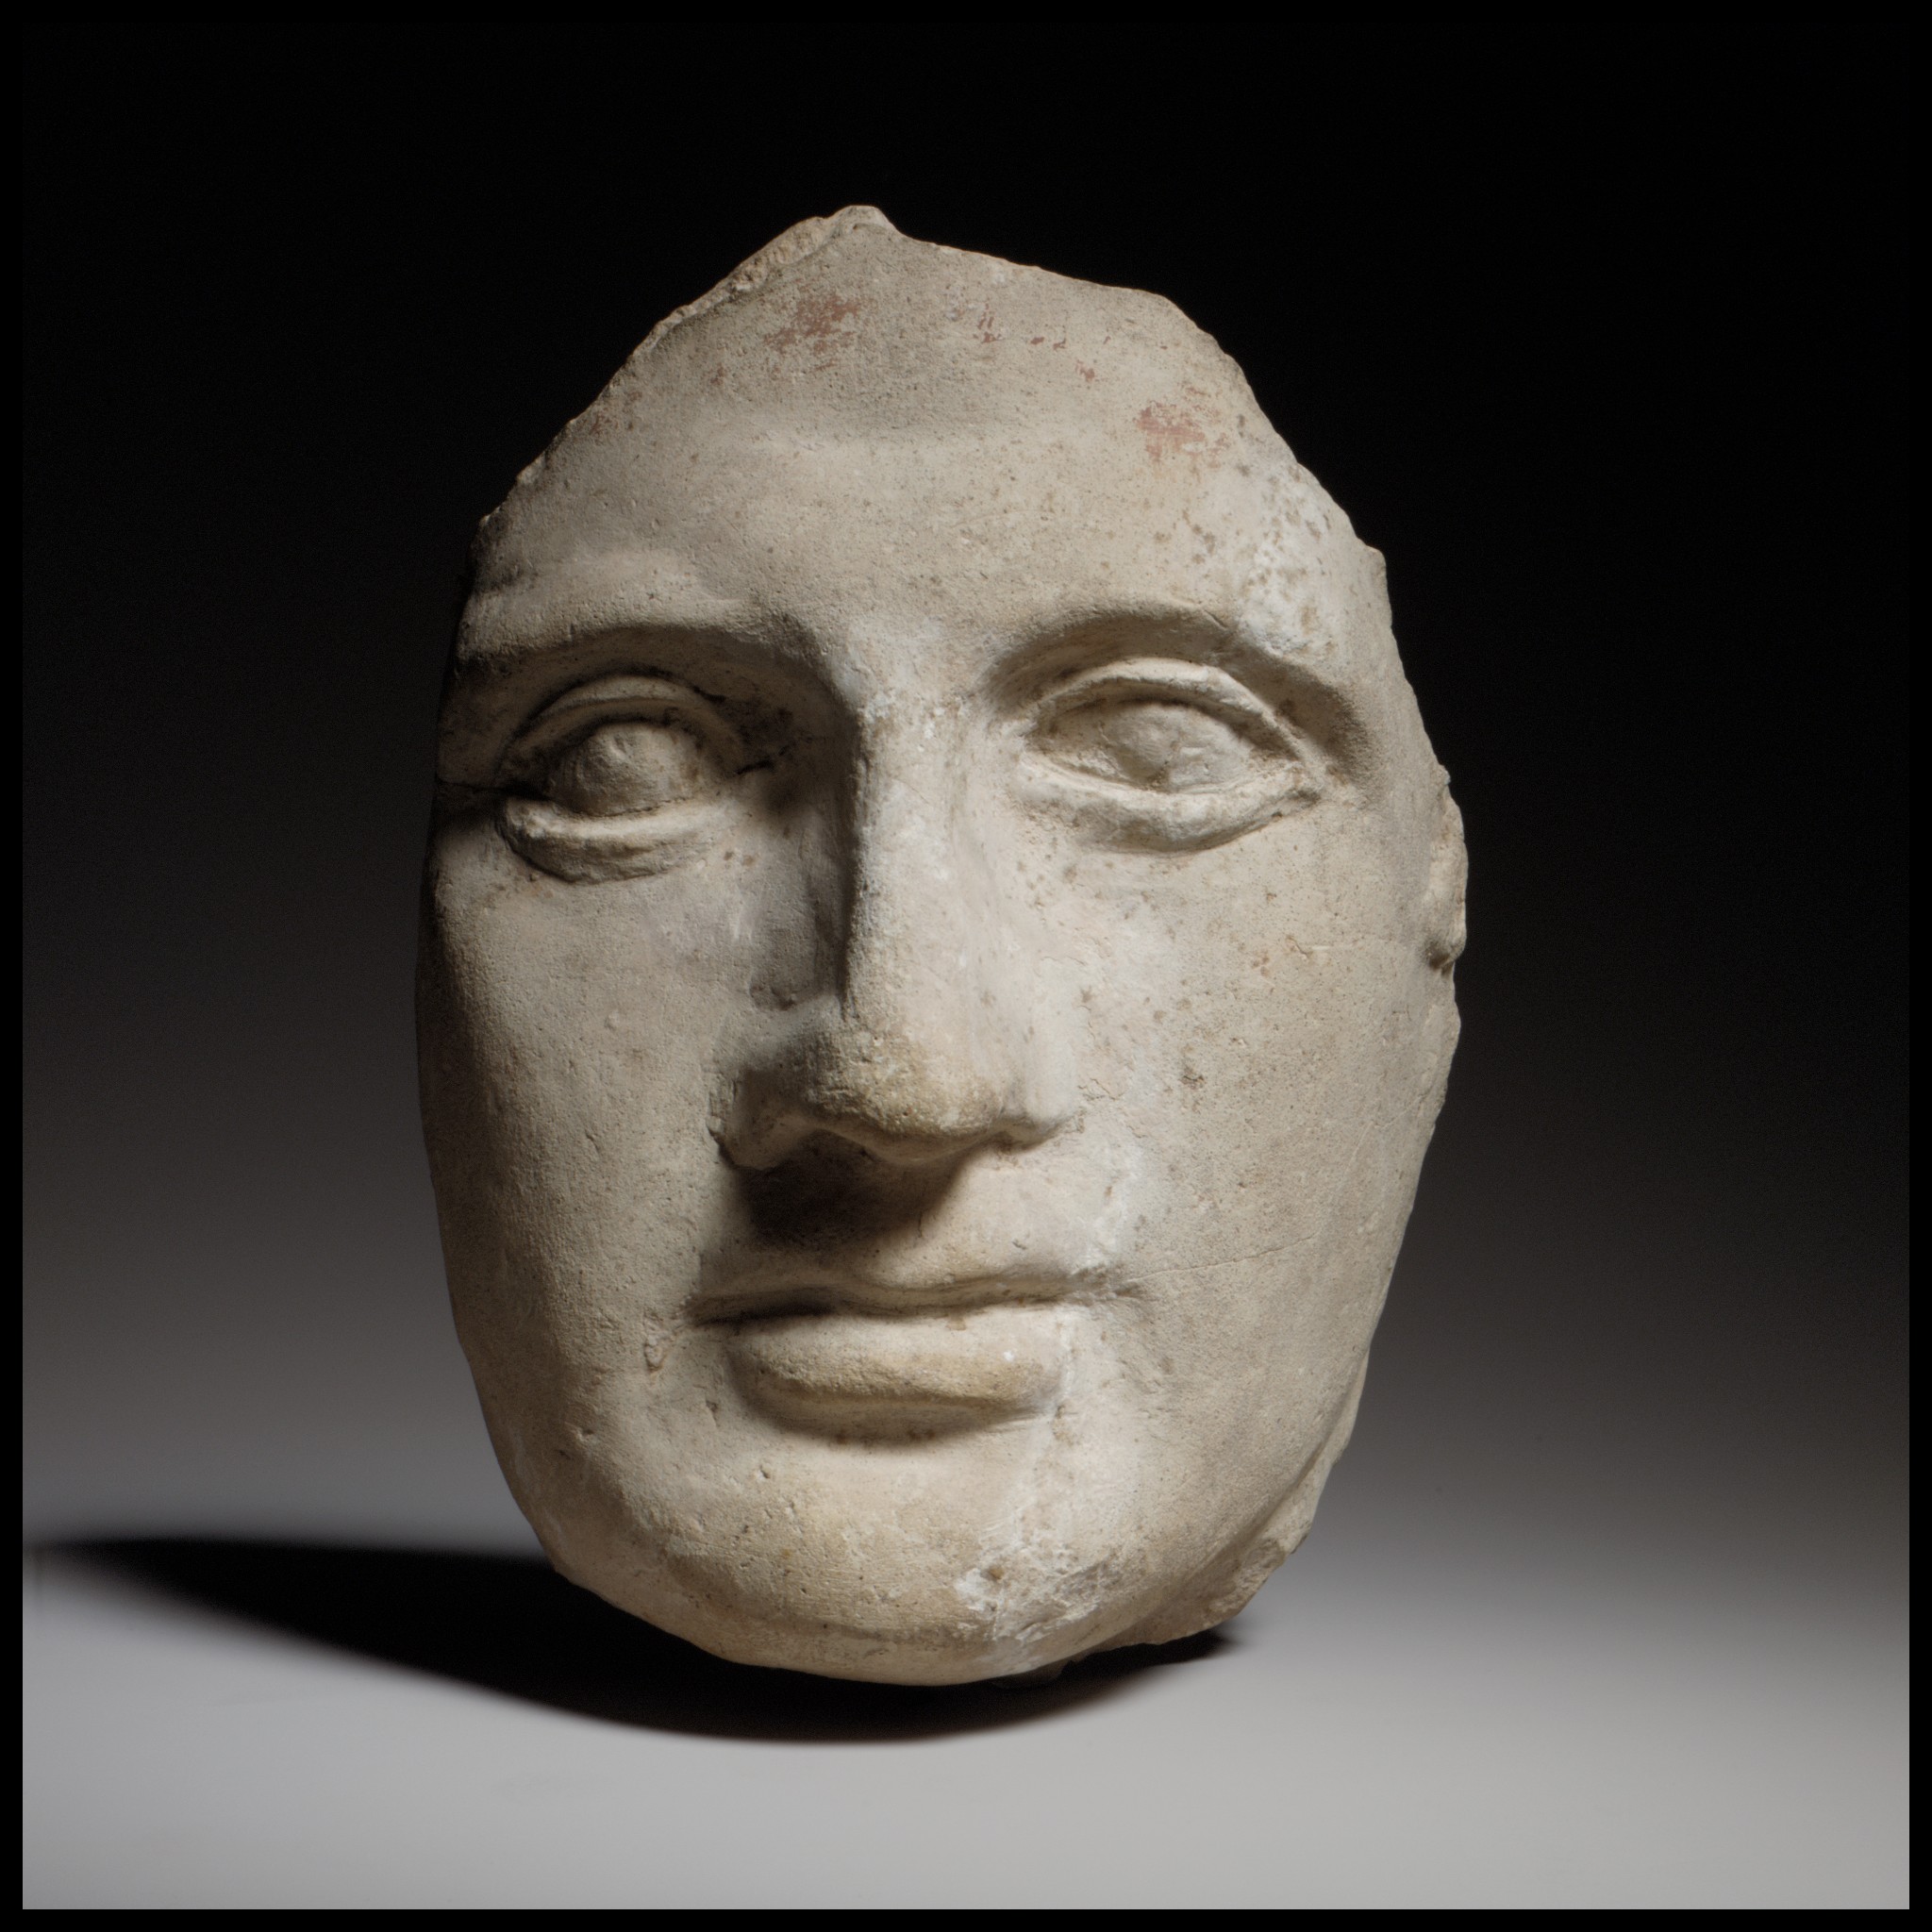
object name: head of a man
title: Fragment of a terracotta head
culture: cypriot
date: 400-301 BCE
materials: terracotta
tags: heads